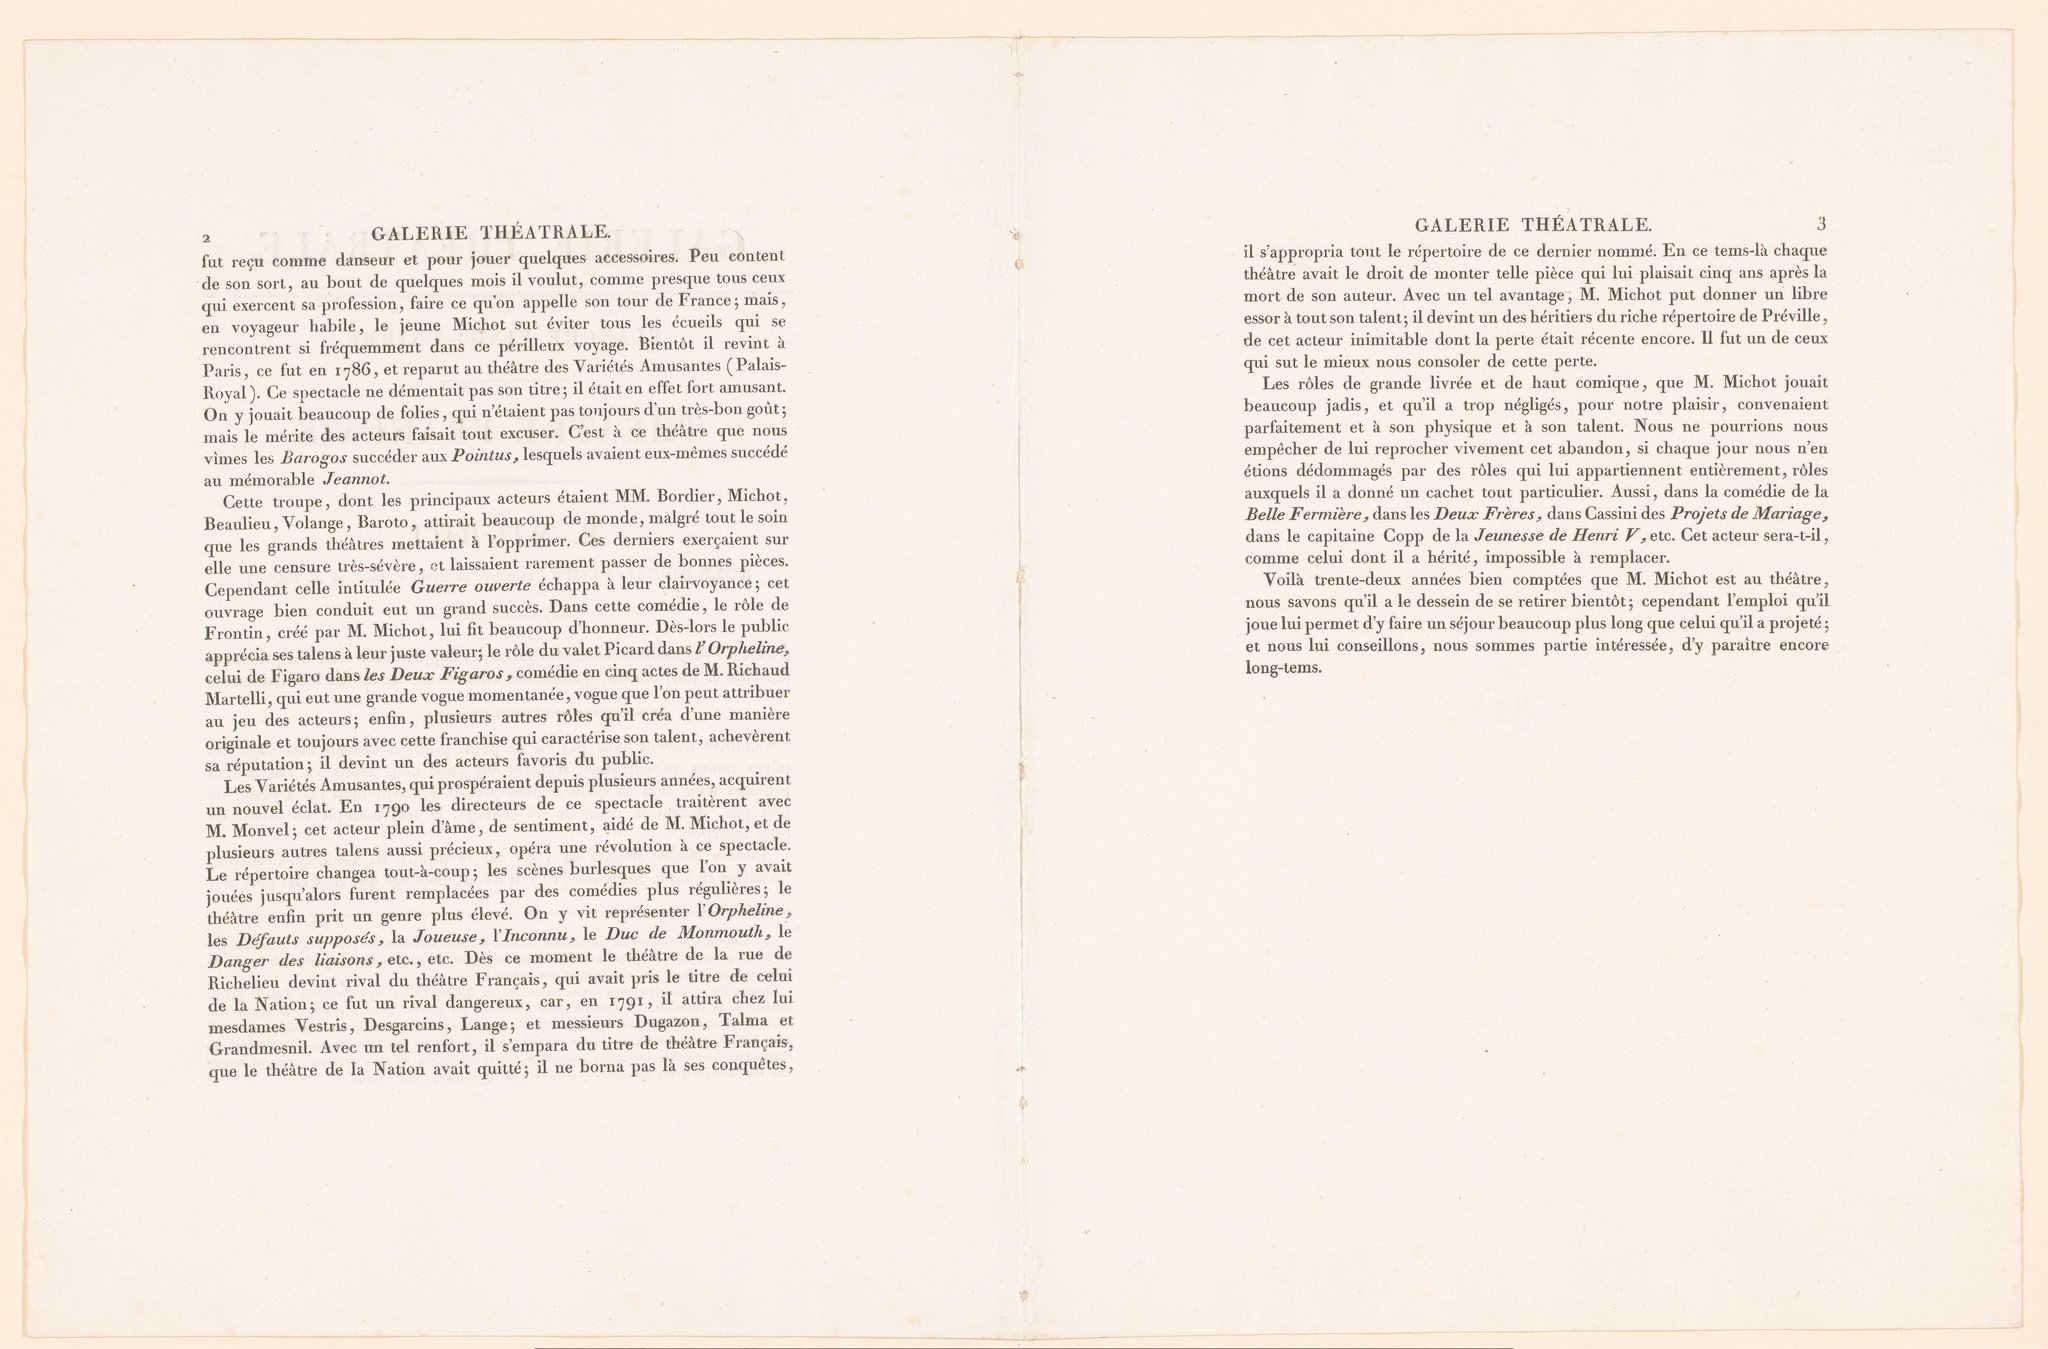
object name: print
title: Portret van acteur Antoine Michaut in de rol van kapitein Copp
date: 1812-1834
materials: paper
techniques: printing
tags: historical persons, actor (on the stage)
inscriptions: : ‘Déposé à la Direction Royle’, collector's mark: Lugt 2228, collector's mark: ‘Cirkel gestempeld in paars met daaromheen de woorden 'School voor de grafische vakken te Utrecht'’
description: Bestaat uit een prent en drie pagina's met informatie over de acteur.